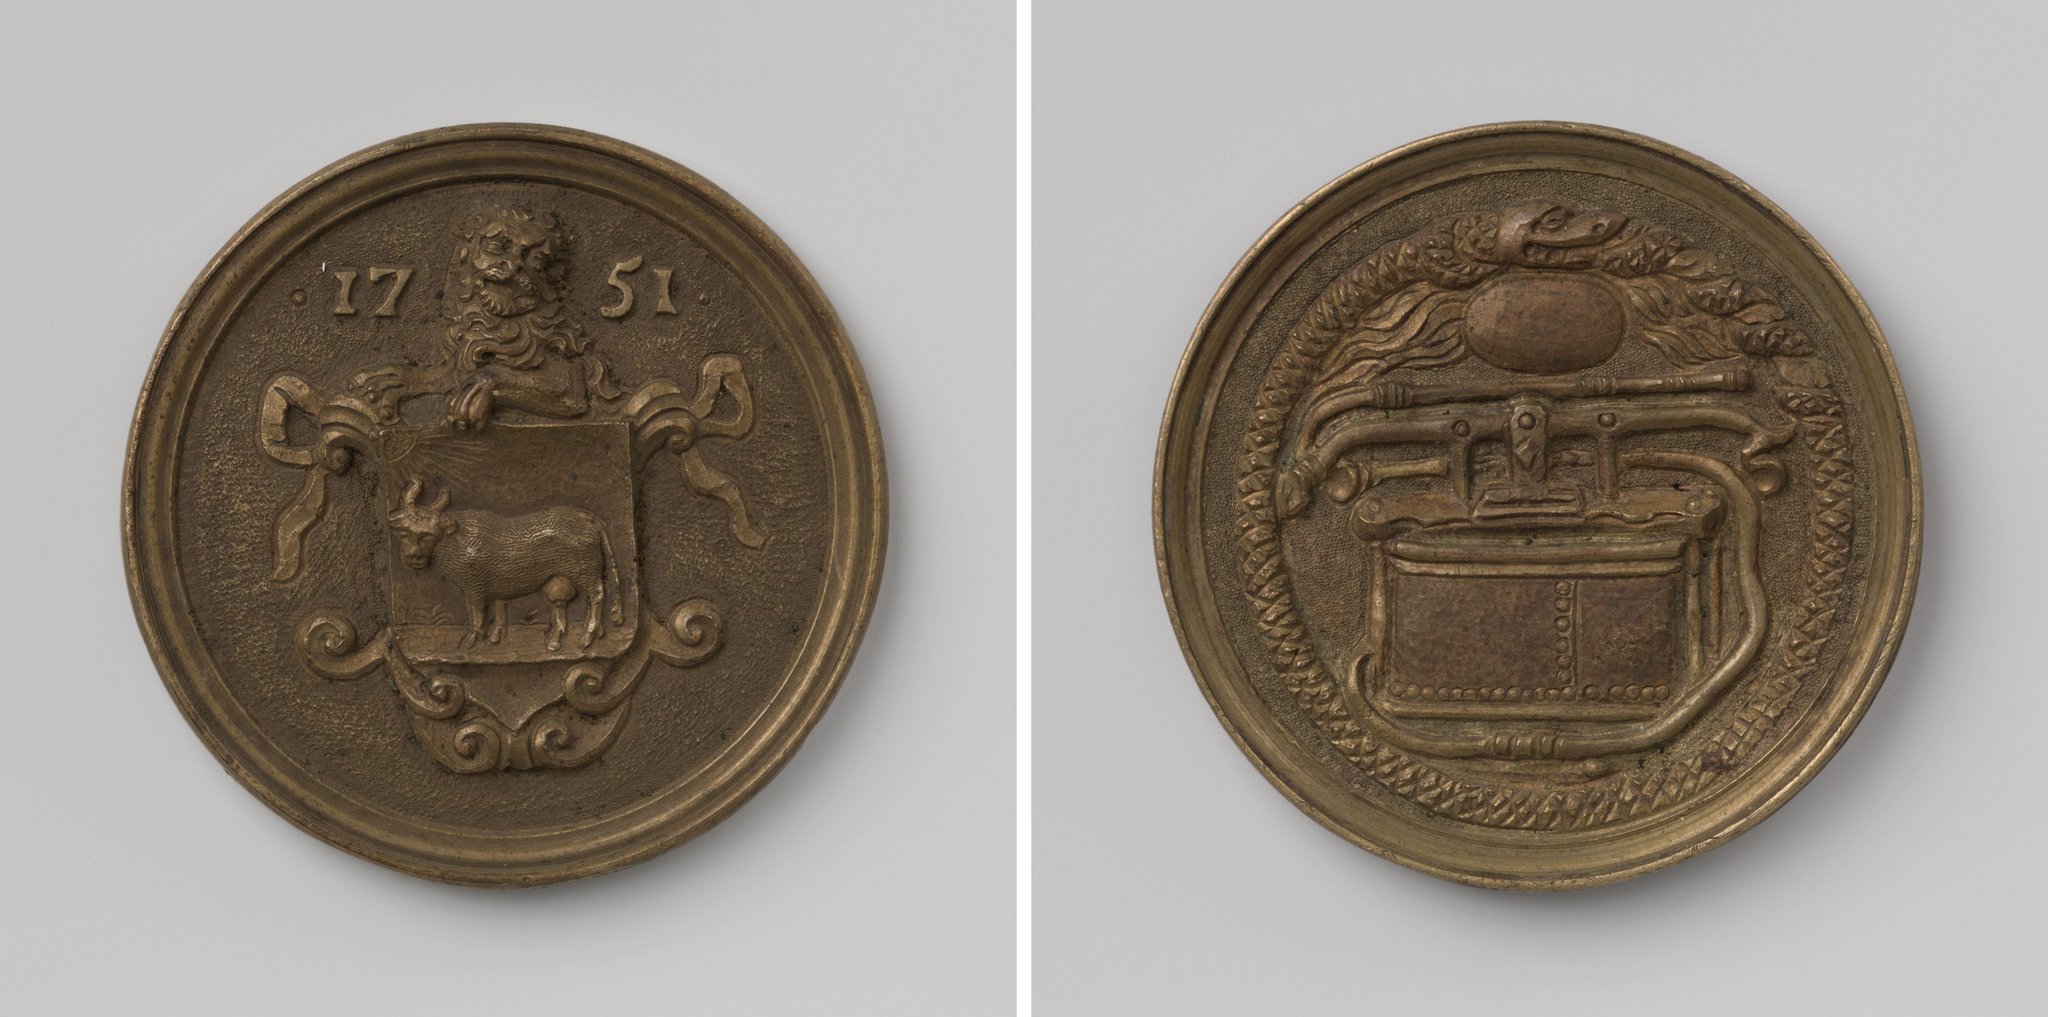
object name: medal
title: Beemster, brandspuitpenning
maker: Anonymous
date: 1751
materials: brass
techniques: casting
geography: beemster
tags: beemster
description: Messing penning. Voorzijde: wapenschild, gedragen door leeuw tussen jaartal. Keerzijde: brandspuit onder leeg cartouche binnen slangerond